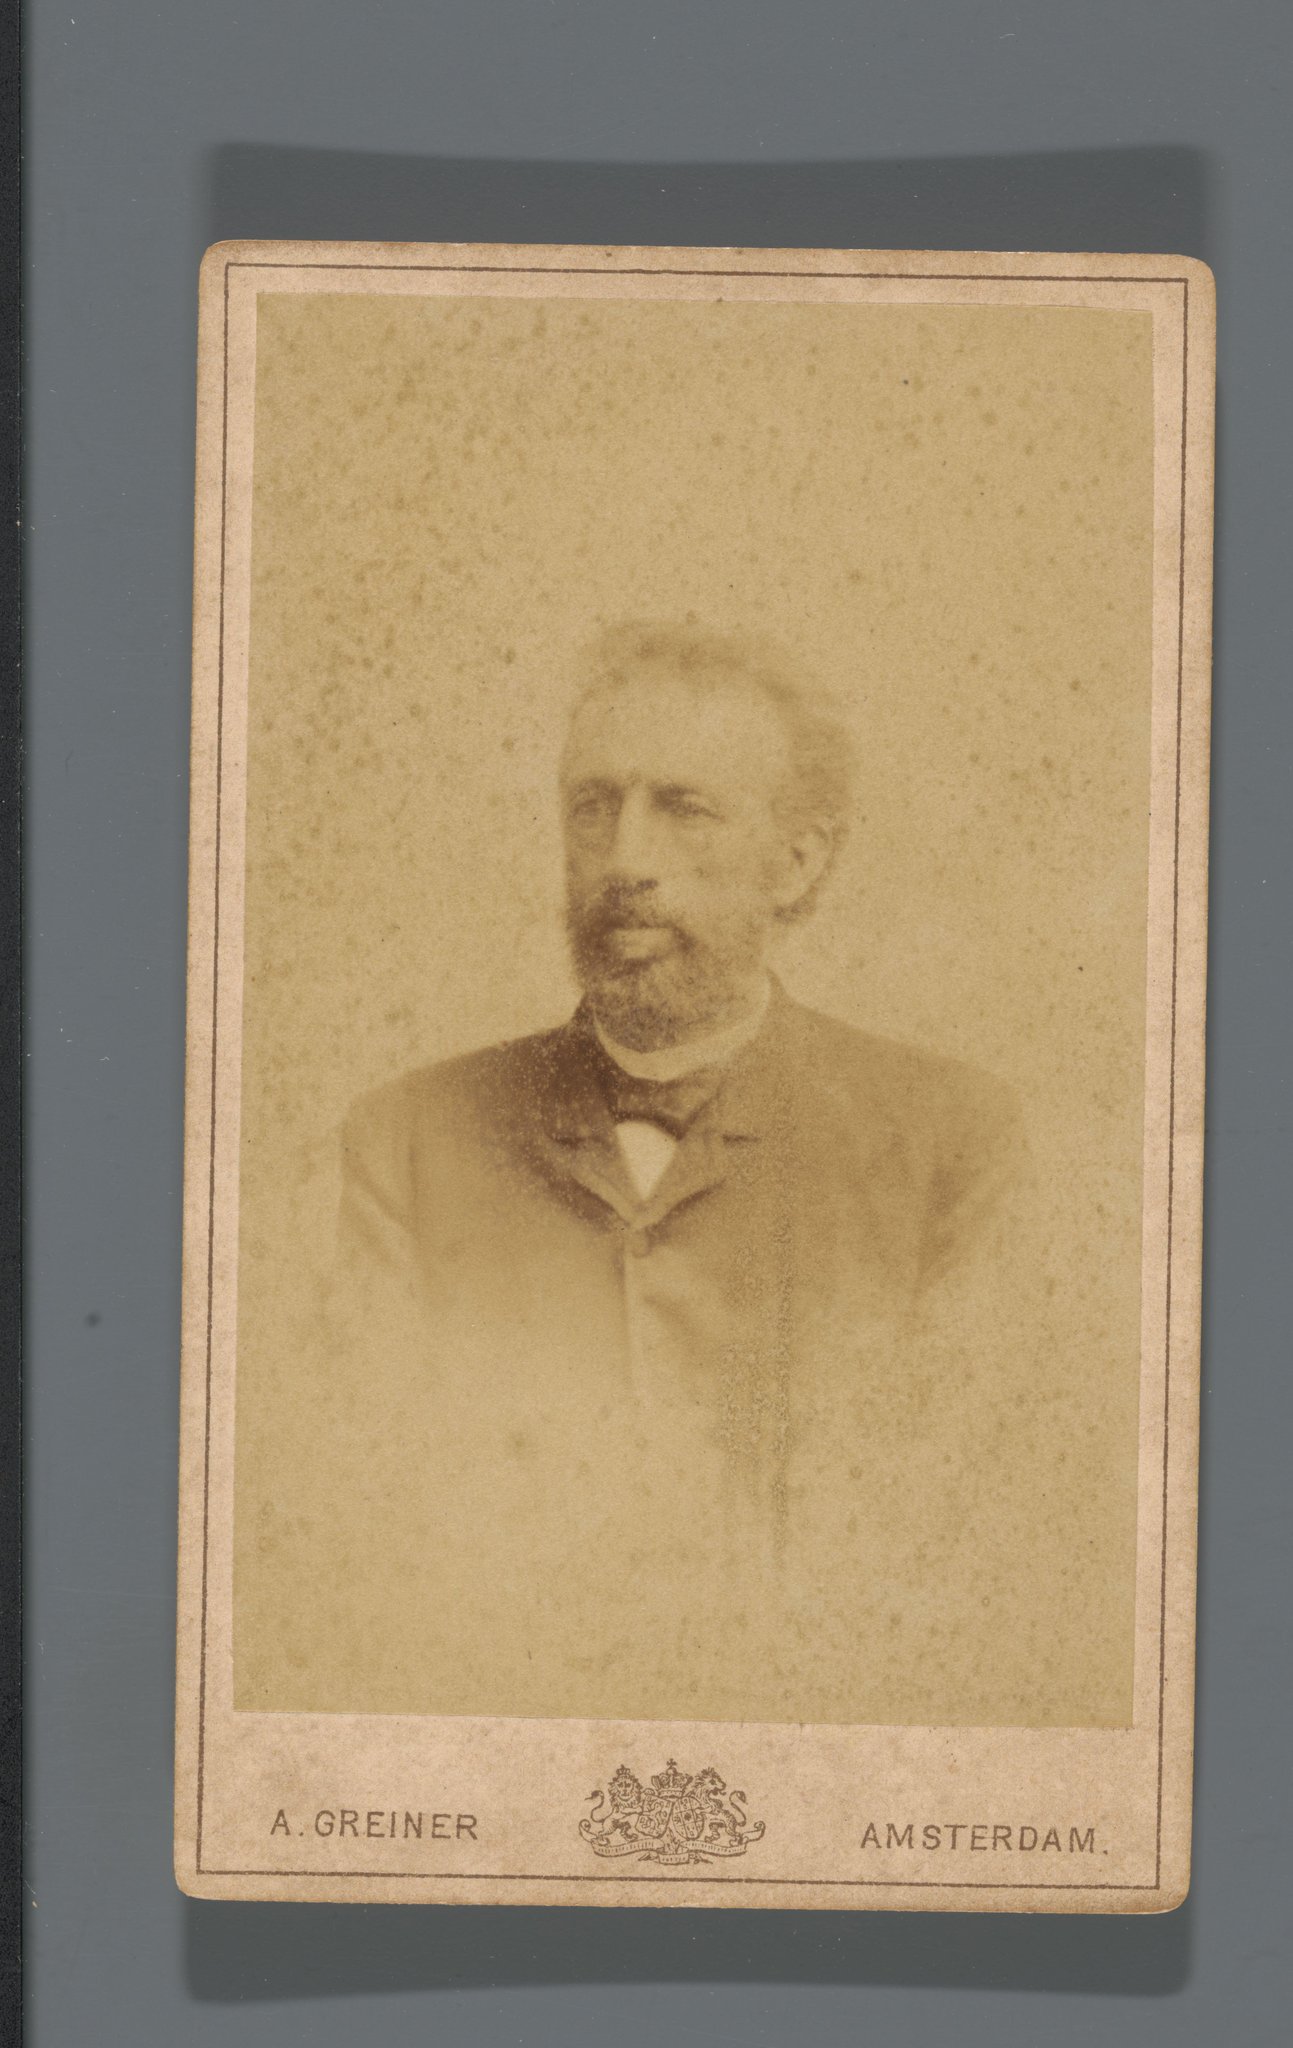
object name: photograph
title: Portret van een man uit de familie Marmelstein, vermoedelijk de vader van A. F. Marmelstein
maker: albert greiner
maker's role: fotograaf, fotostudio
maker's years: 1833-1890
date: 1850-1900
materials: cardboard, photographic support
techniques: albumen print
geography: amsterdam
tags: adult man, historical persons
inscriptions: retailer's mark: ‘Albert Greiner/ Kon. Ned. Hof-Photograaf/ Amsterdam/ Nieuwendijk 89. (...)’, workshop stamp: ‘Proefkaart/ A. Greiner’